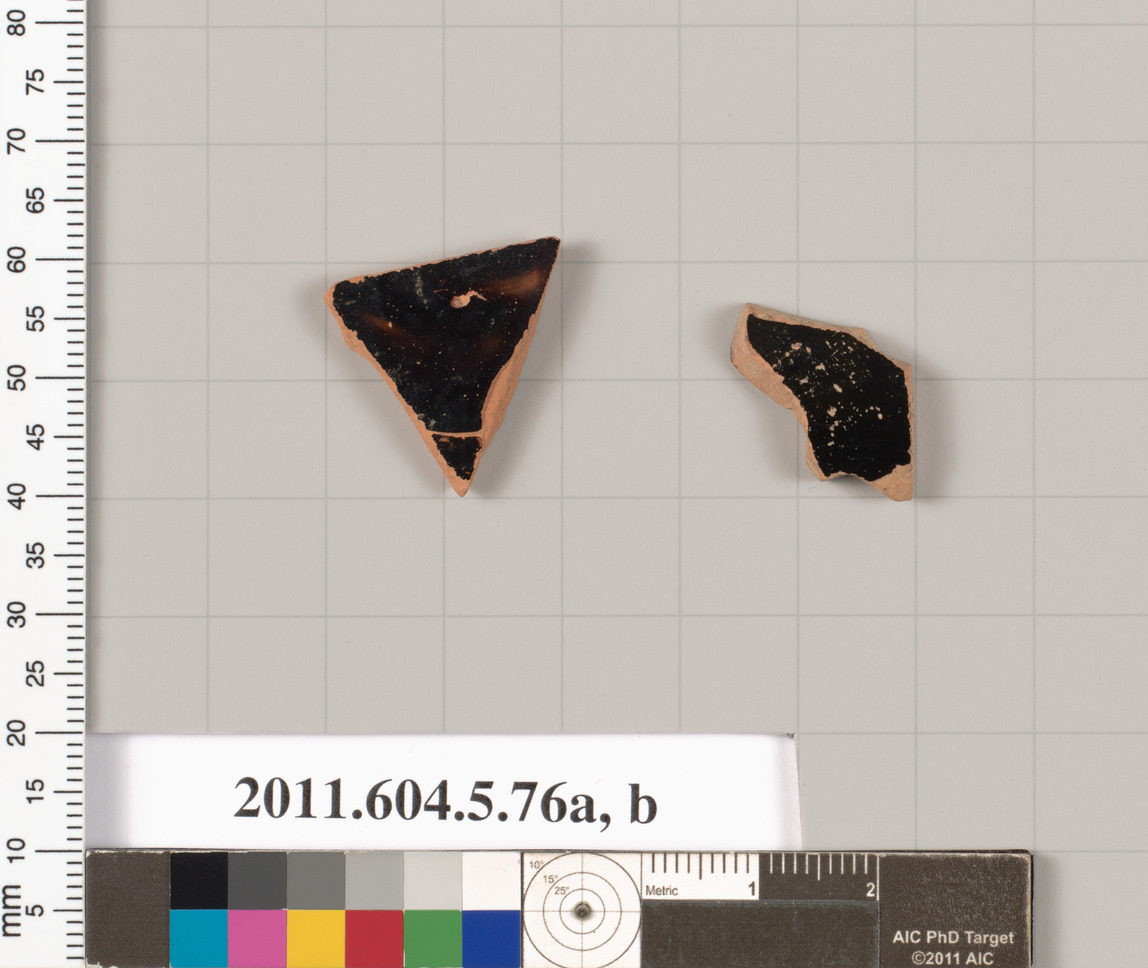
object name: kylix fragment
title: Terracotta fragments of kylikes (drinking cups)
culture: greek, attic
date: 500-451 BCE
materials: terracotta